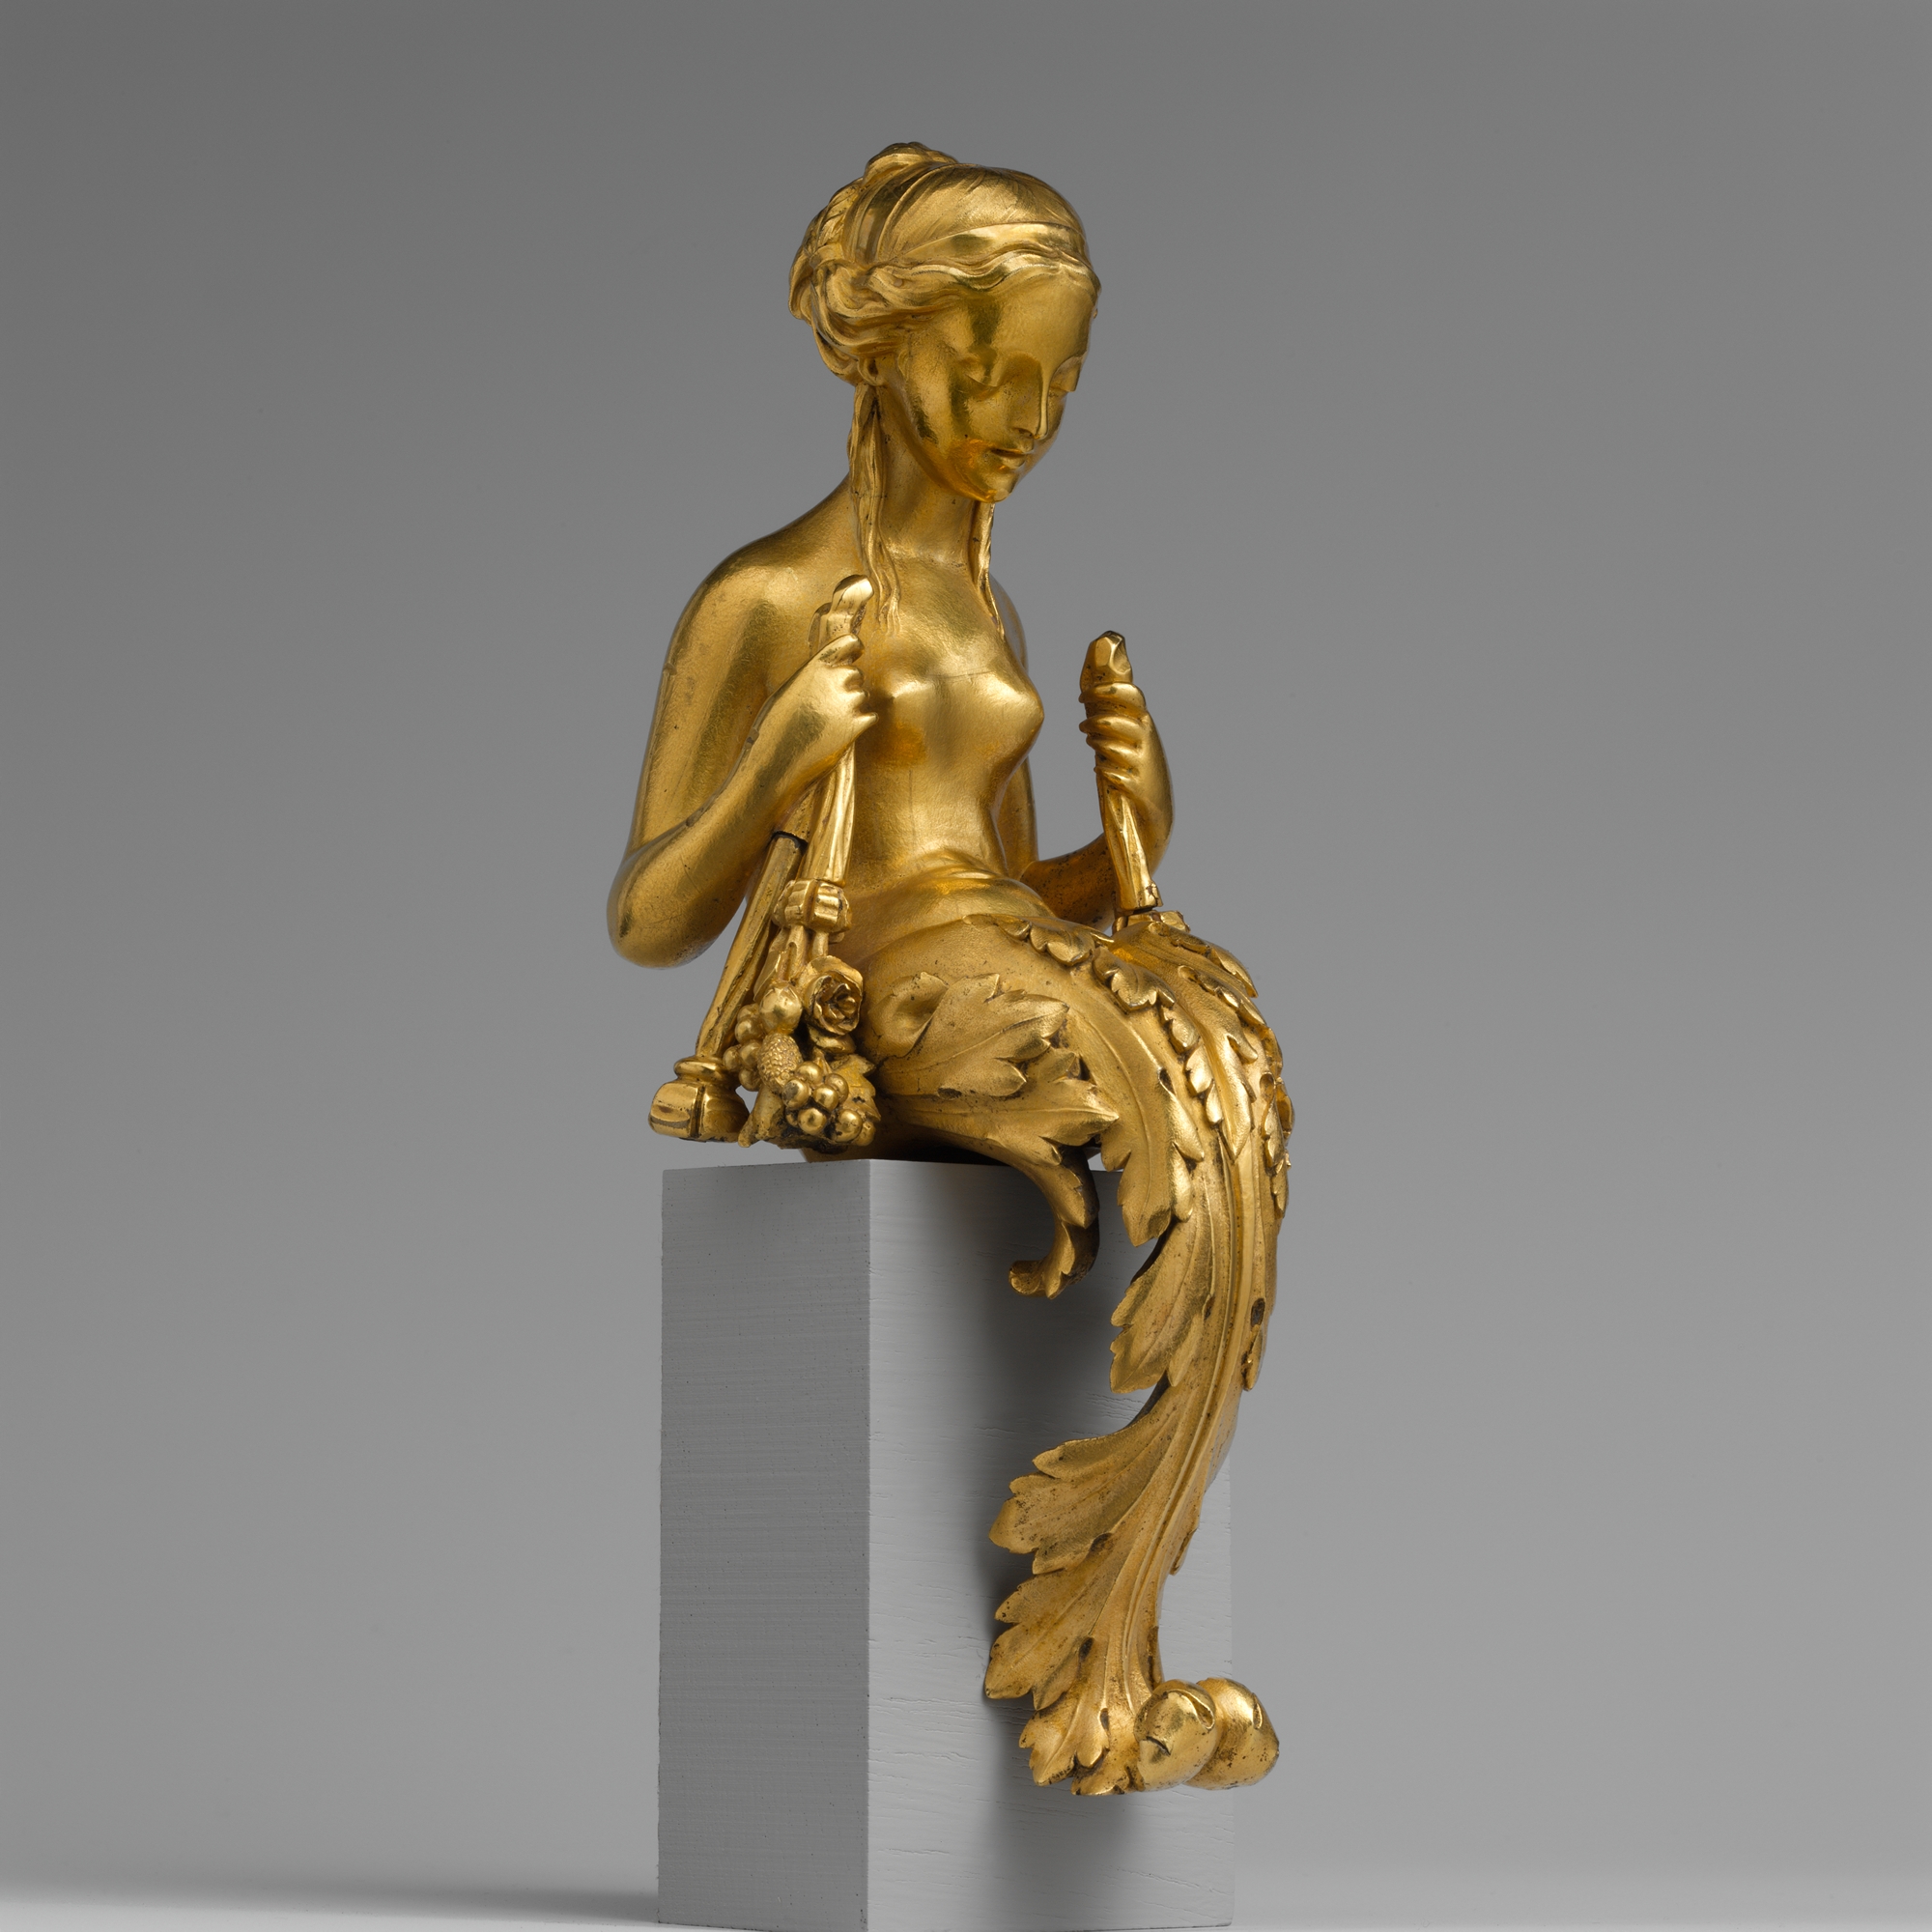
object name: vase or clock ornament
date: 1770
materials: gilt bronze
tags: female nudes,nymphs